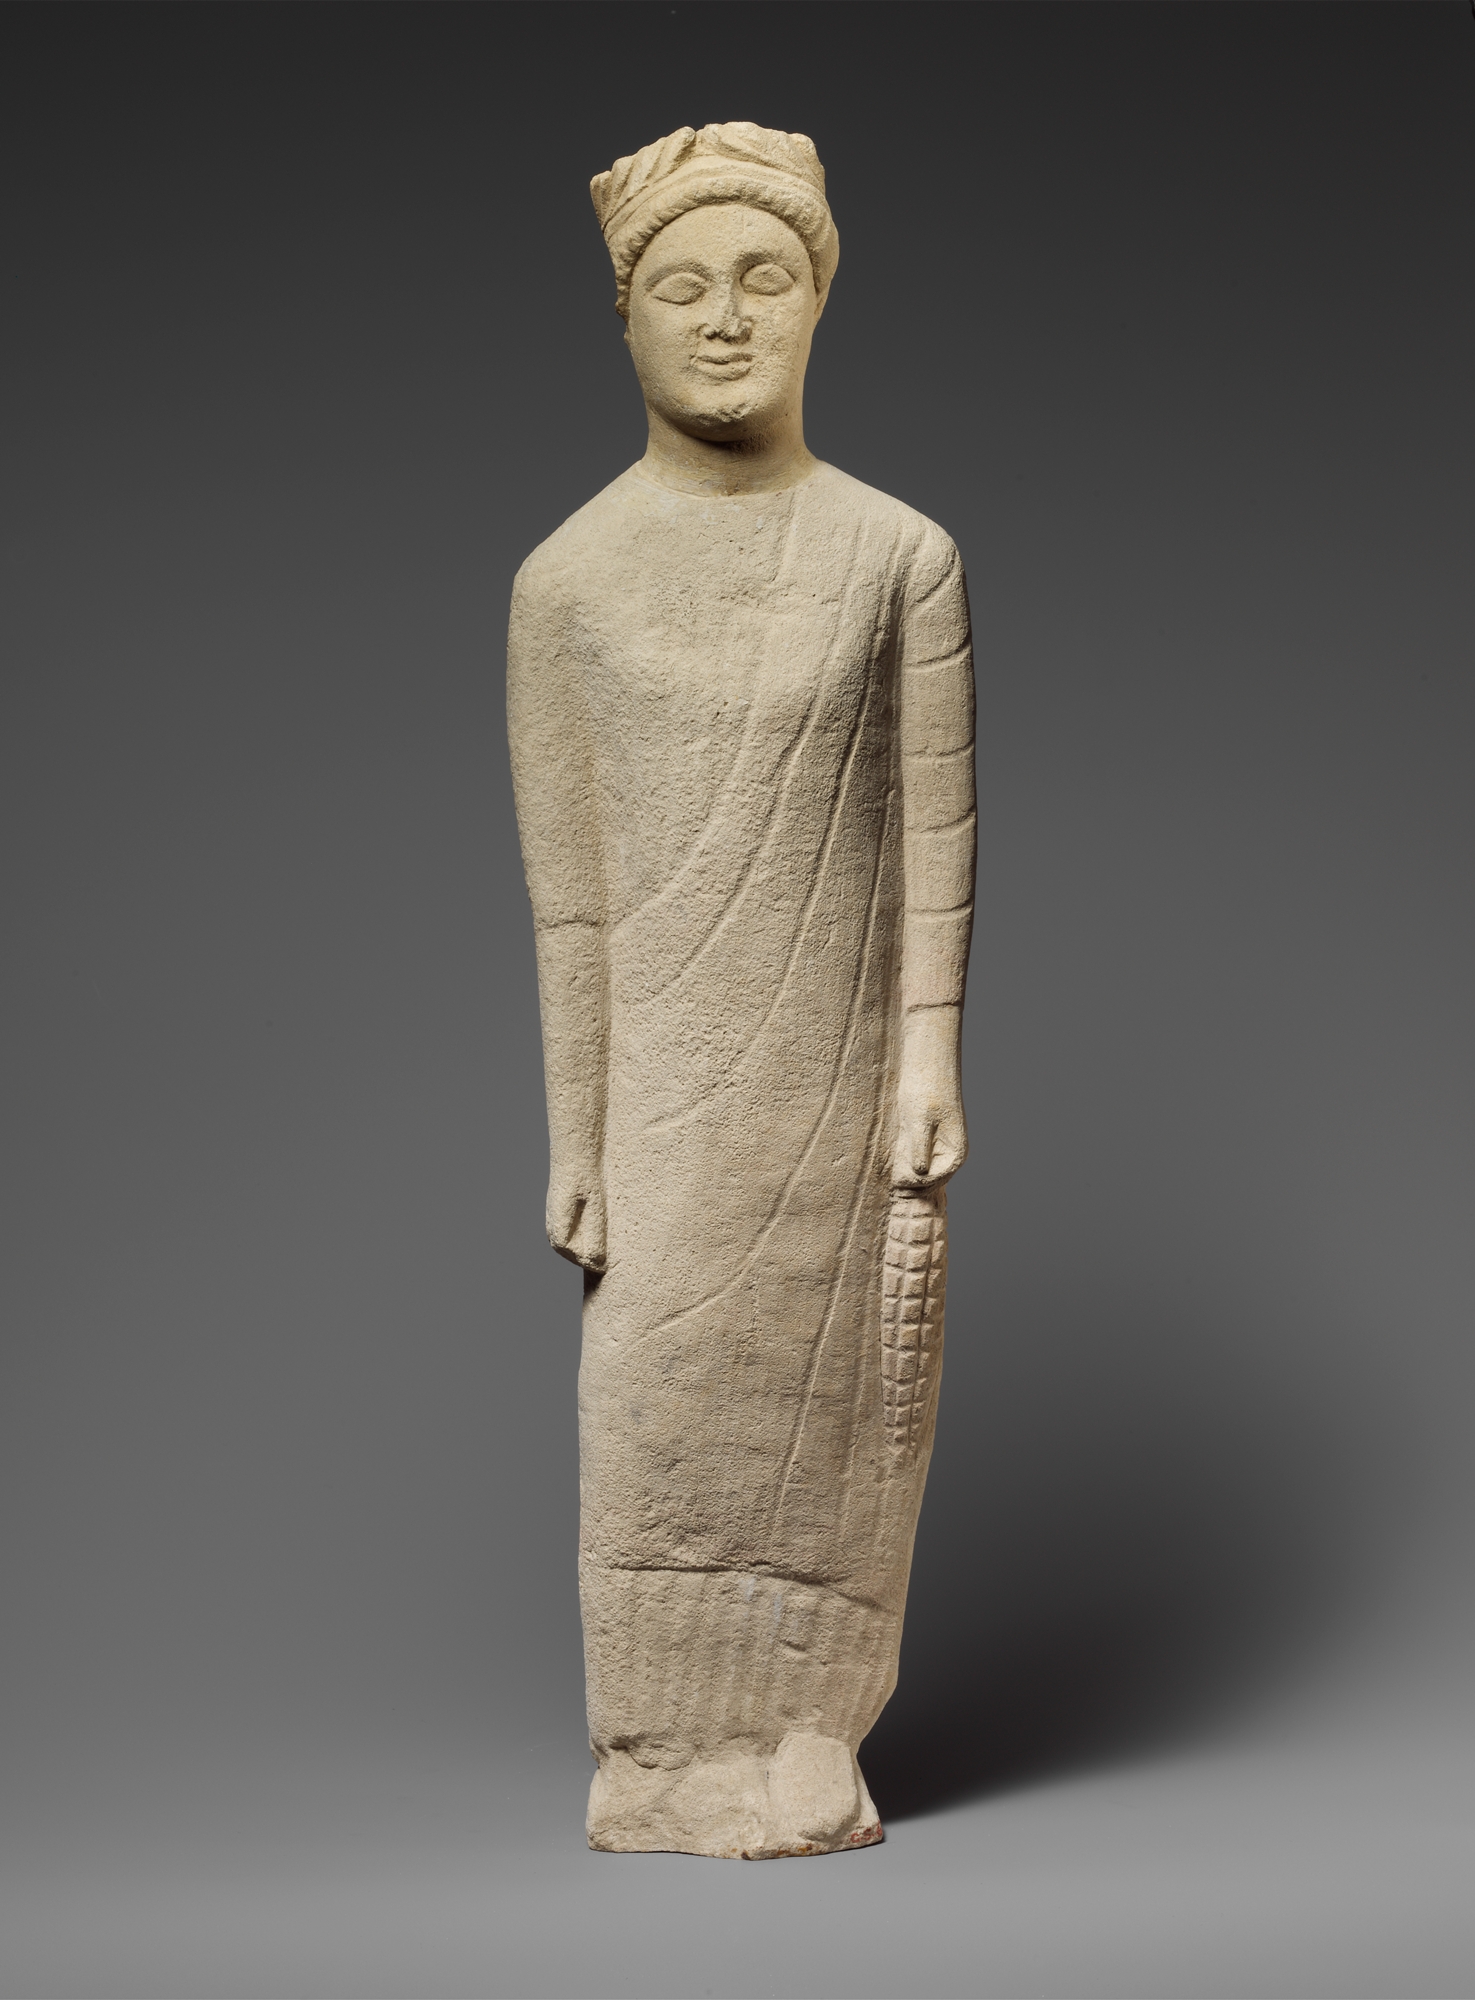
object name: statue of a votary, male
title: Limestone statuette of a beardless male votary with a wreath of leaves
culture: cypriot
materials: limestone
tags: men